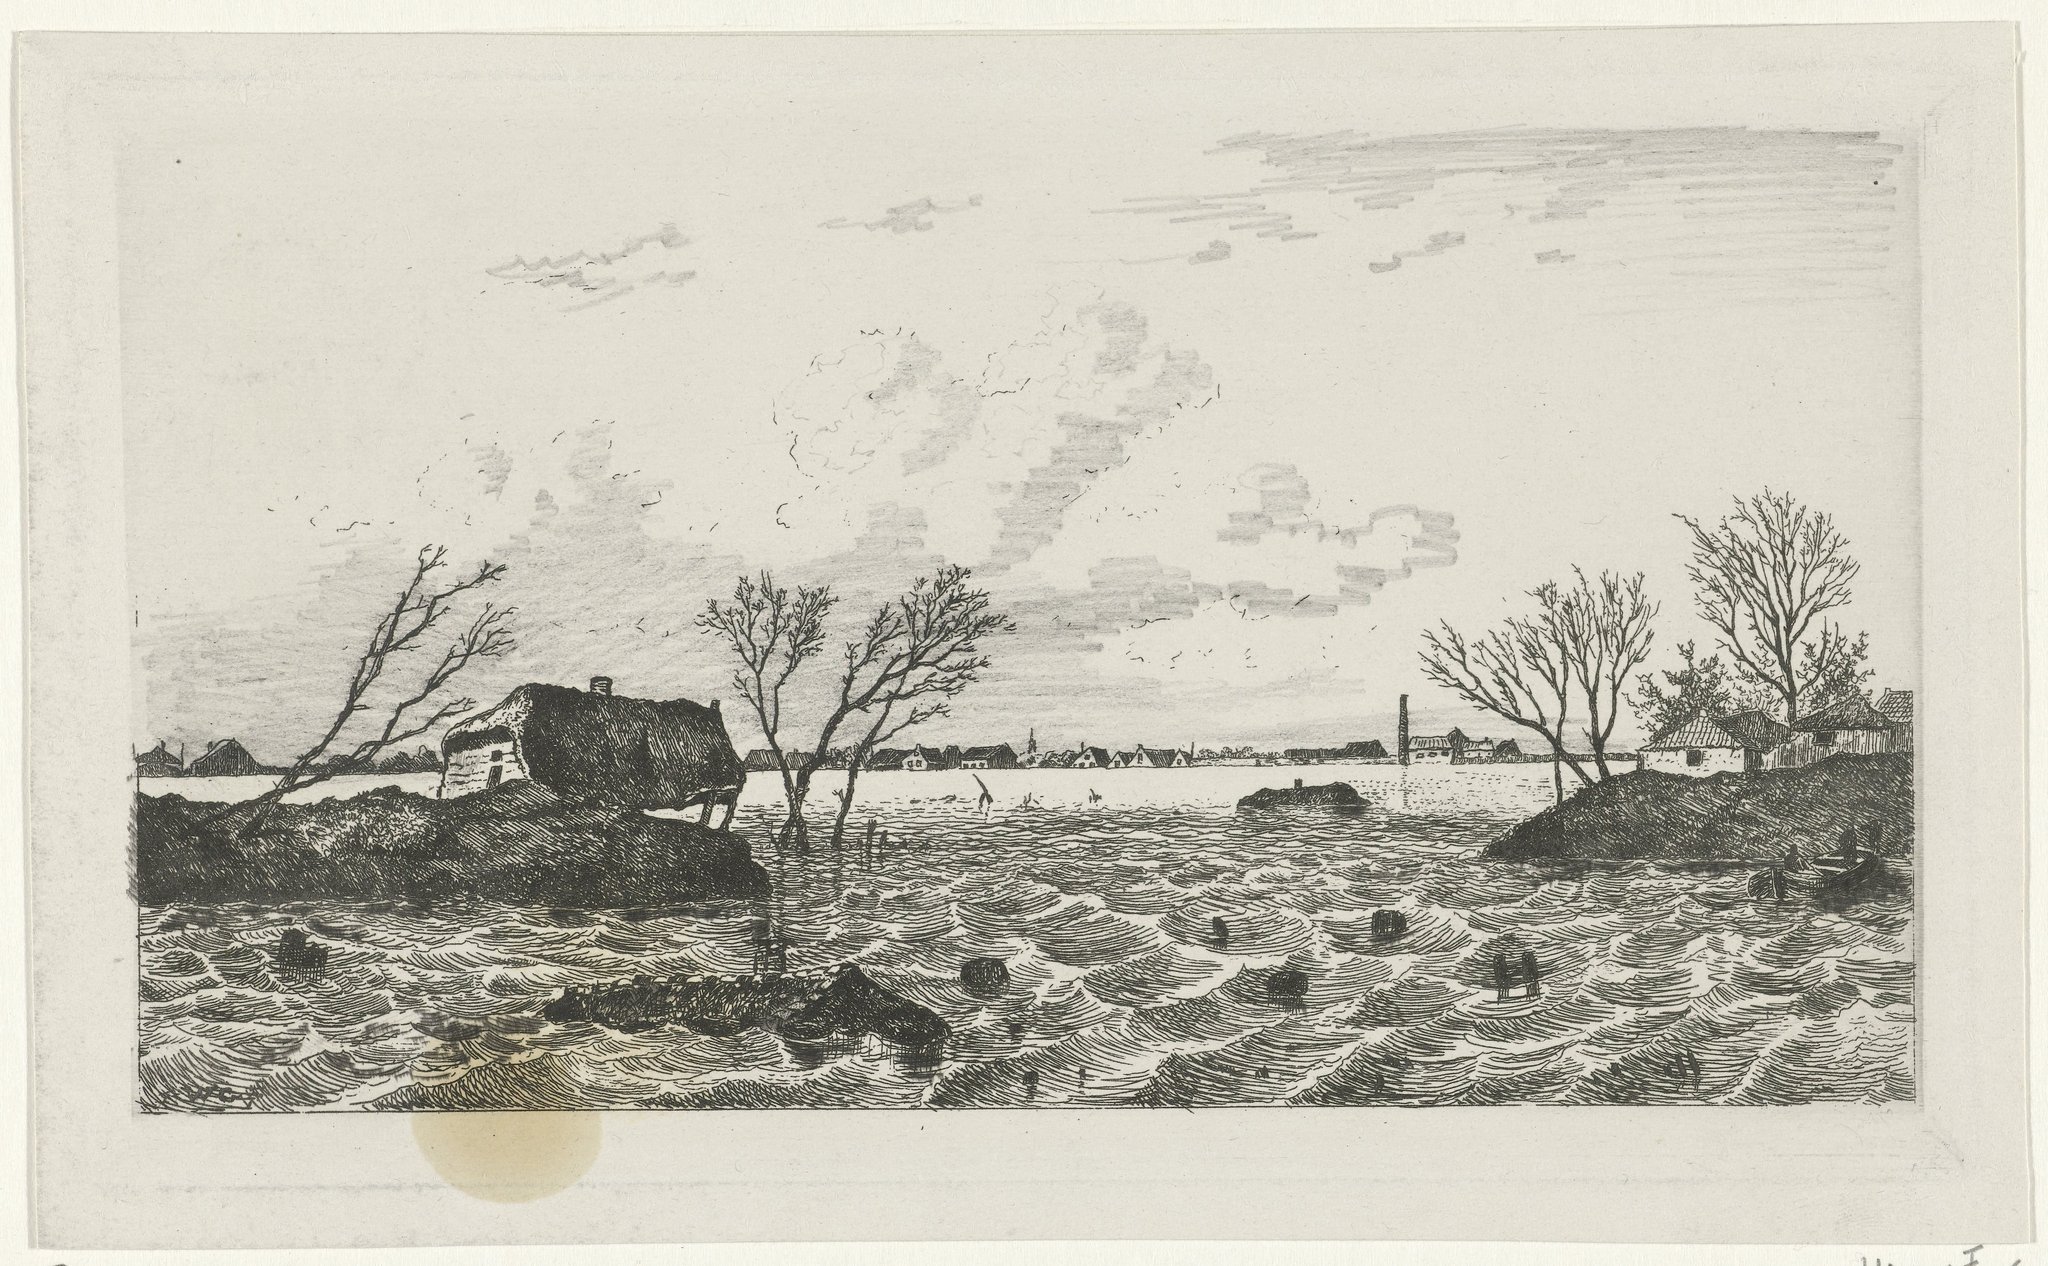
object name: print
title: Dijkdoorbraak bij Dreumel, 1855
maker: willem gruyter jr.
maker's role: draughtsman, print maker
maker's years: 1817-1880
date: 1832-1880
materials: paper, pencil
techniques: etching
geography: amsterdam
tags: dike-break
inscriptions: collector's mark: Lugt 2165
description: Landschap met dijkdoorbraak bij Dreumel tijdens de watersnoodramp in 1855.